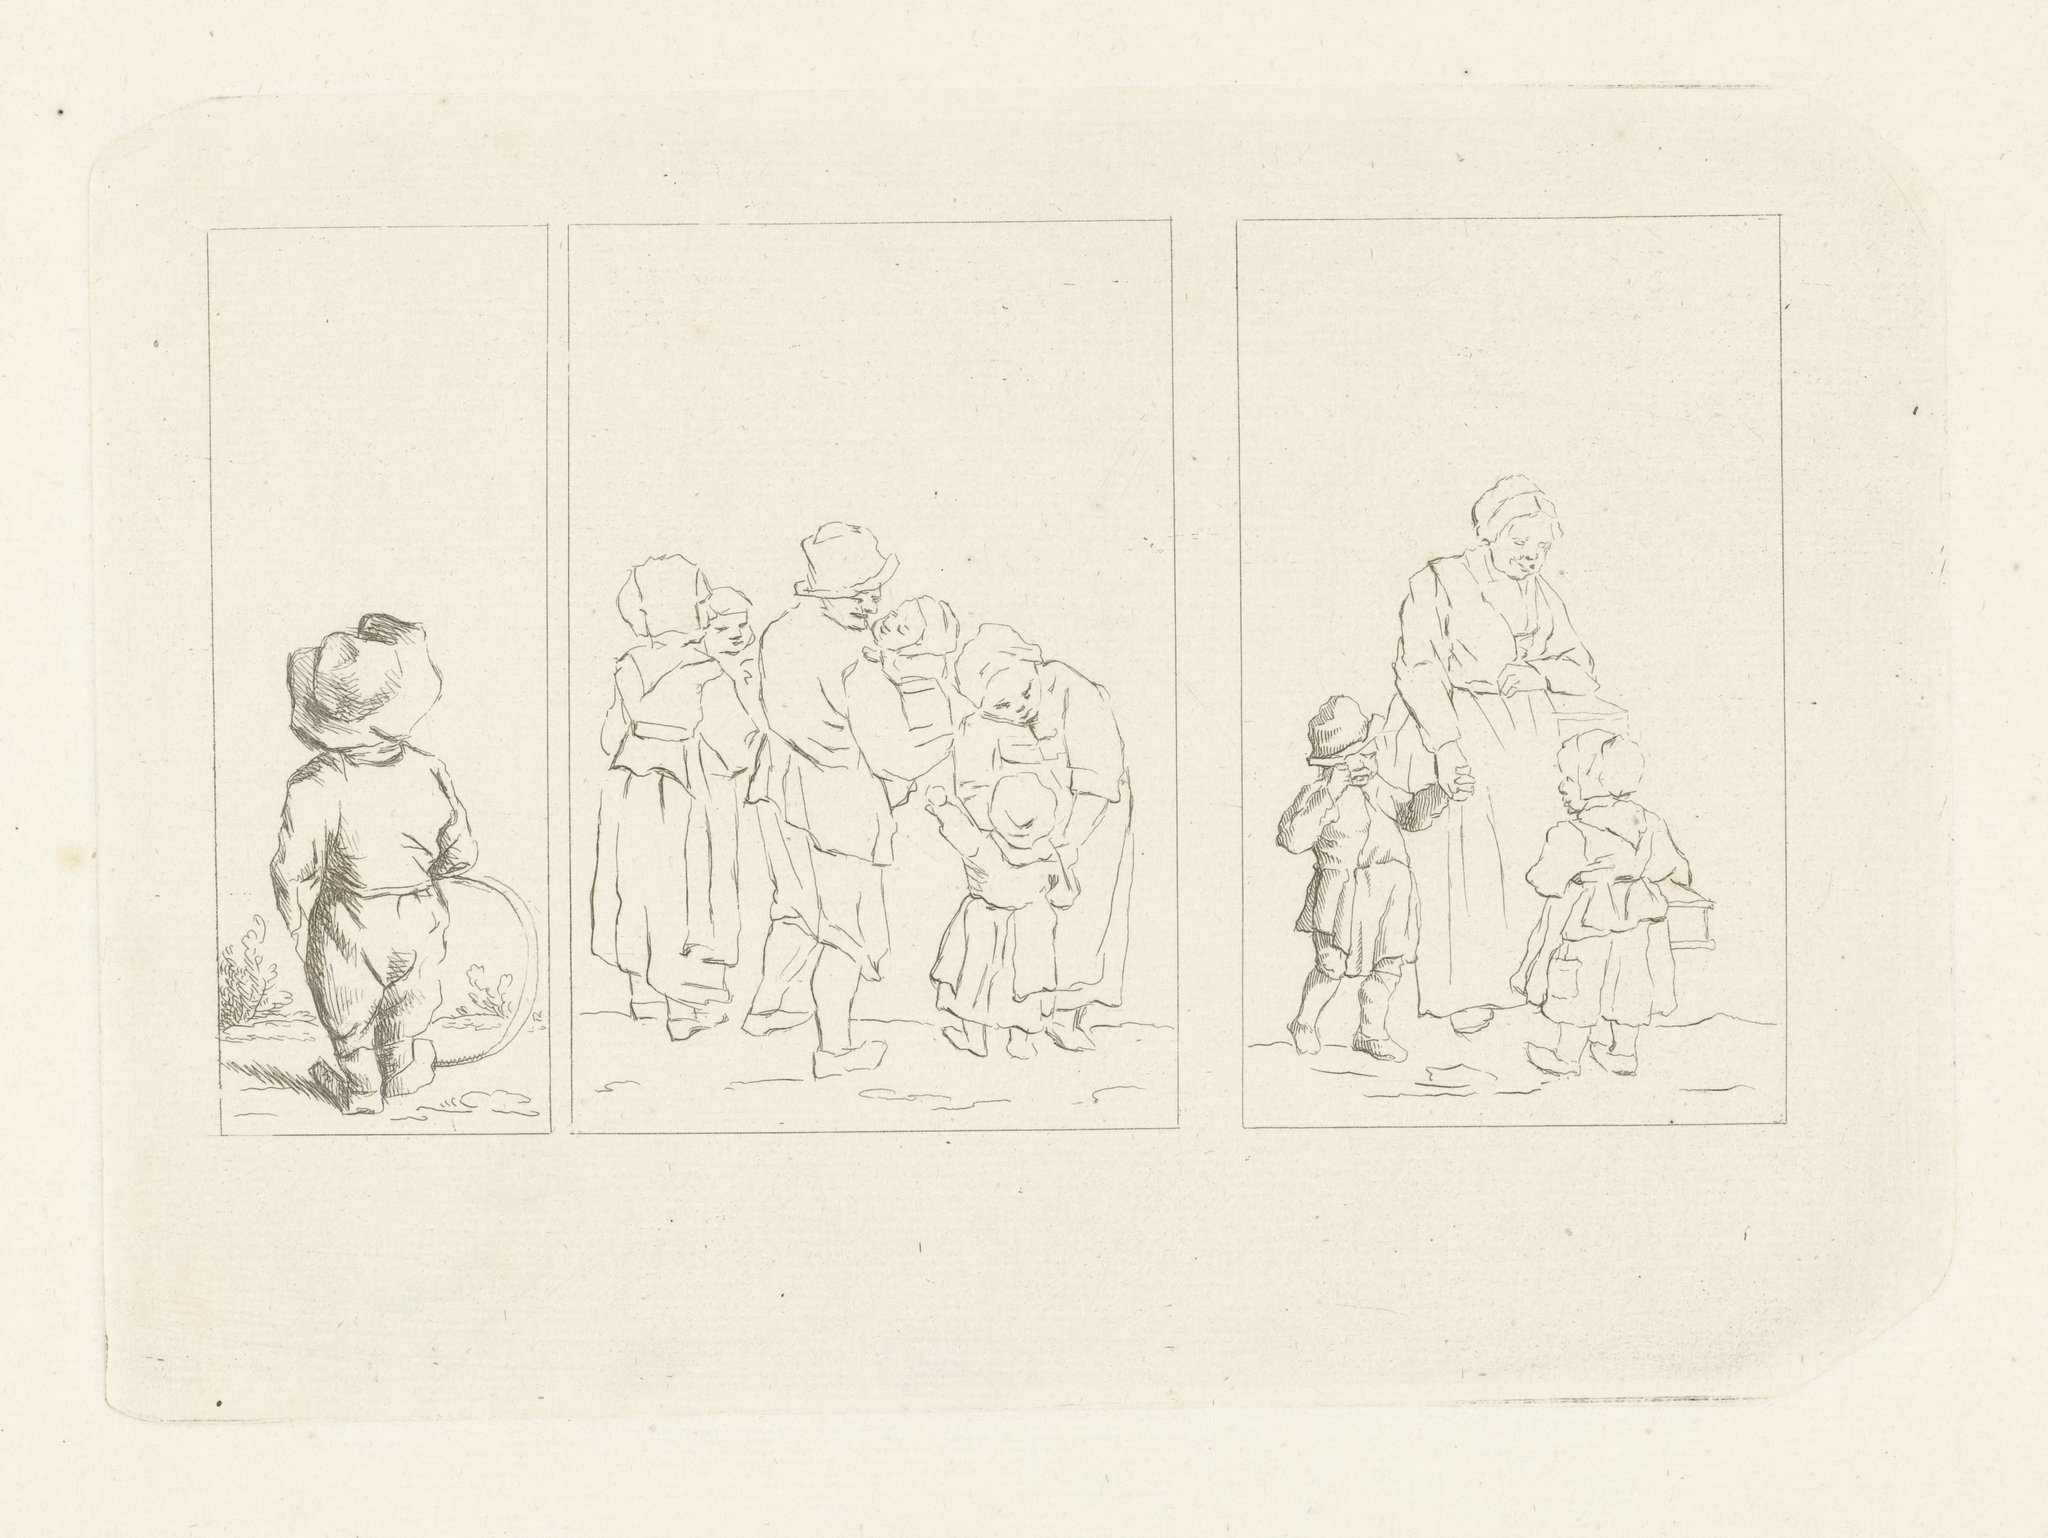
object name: print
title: Kinderen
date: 1768-1846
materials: paper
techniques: etching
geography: netherlands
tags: taking care of children - aa - by other children, (bowling a) hoop, weeping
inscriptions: collector's mark: Lugt 2228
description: Drie voorstellingen van kinderen. Links: een jongen op de rug gezien, staande met een hoepel in de hand. Midden: een groep oudere kinderen, ieder met een jong kind op de arm. Rechts: een moeder met een huilende jongen aan de hand. Daarbij een meisje.